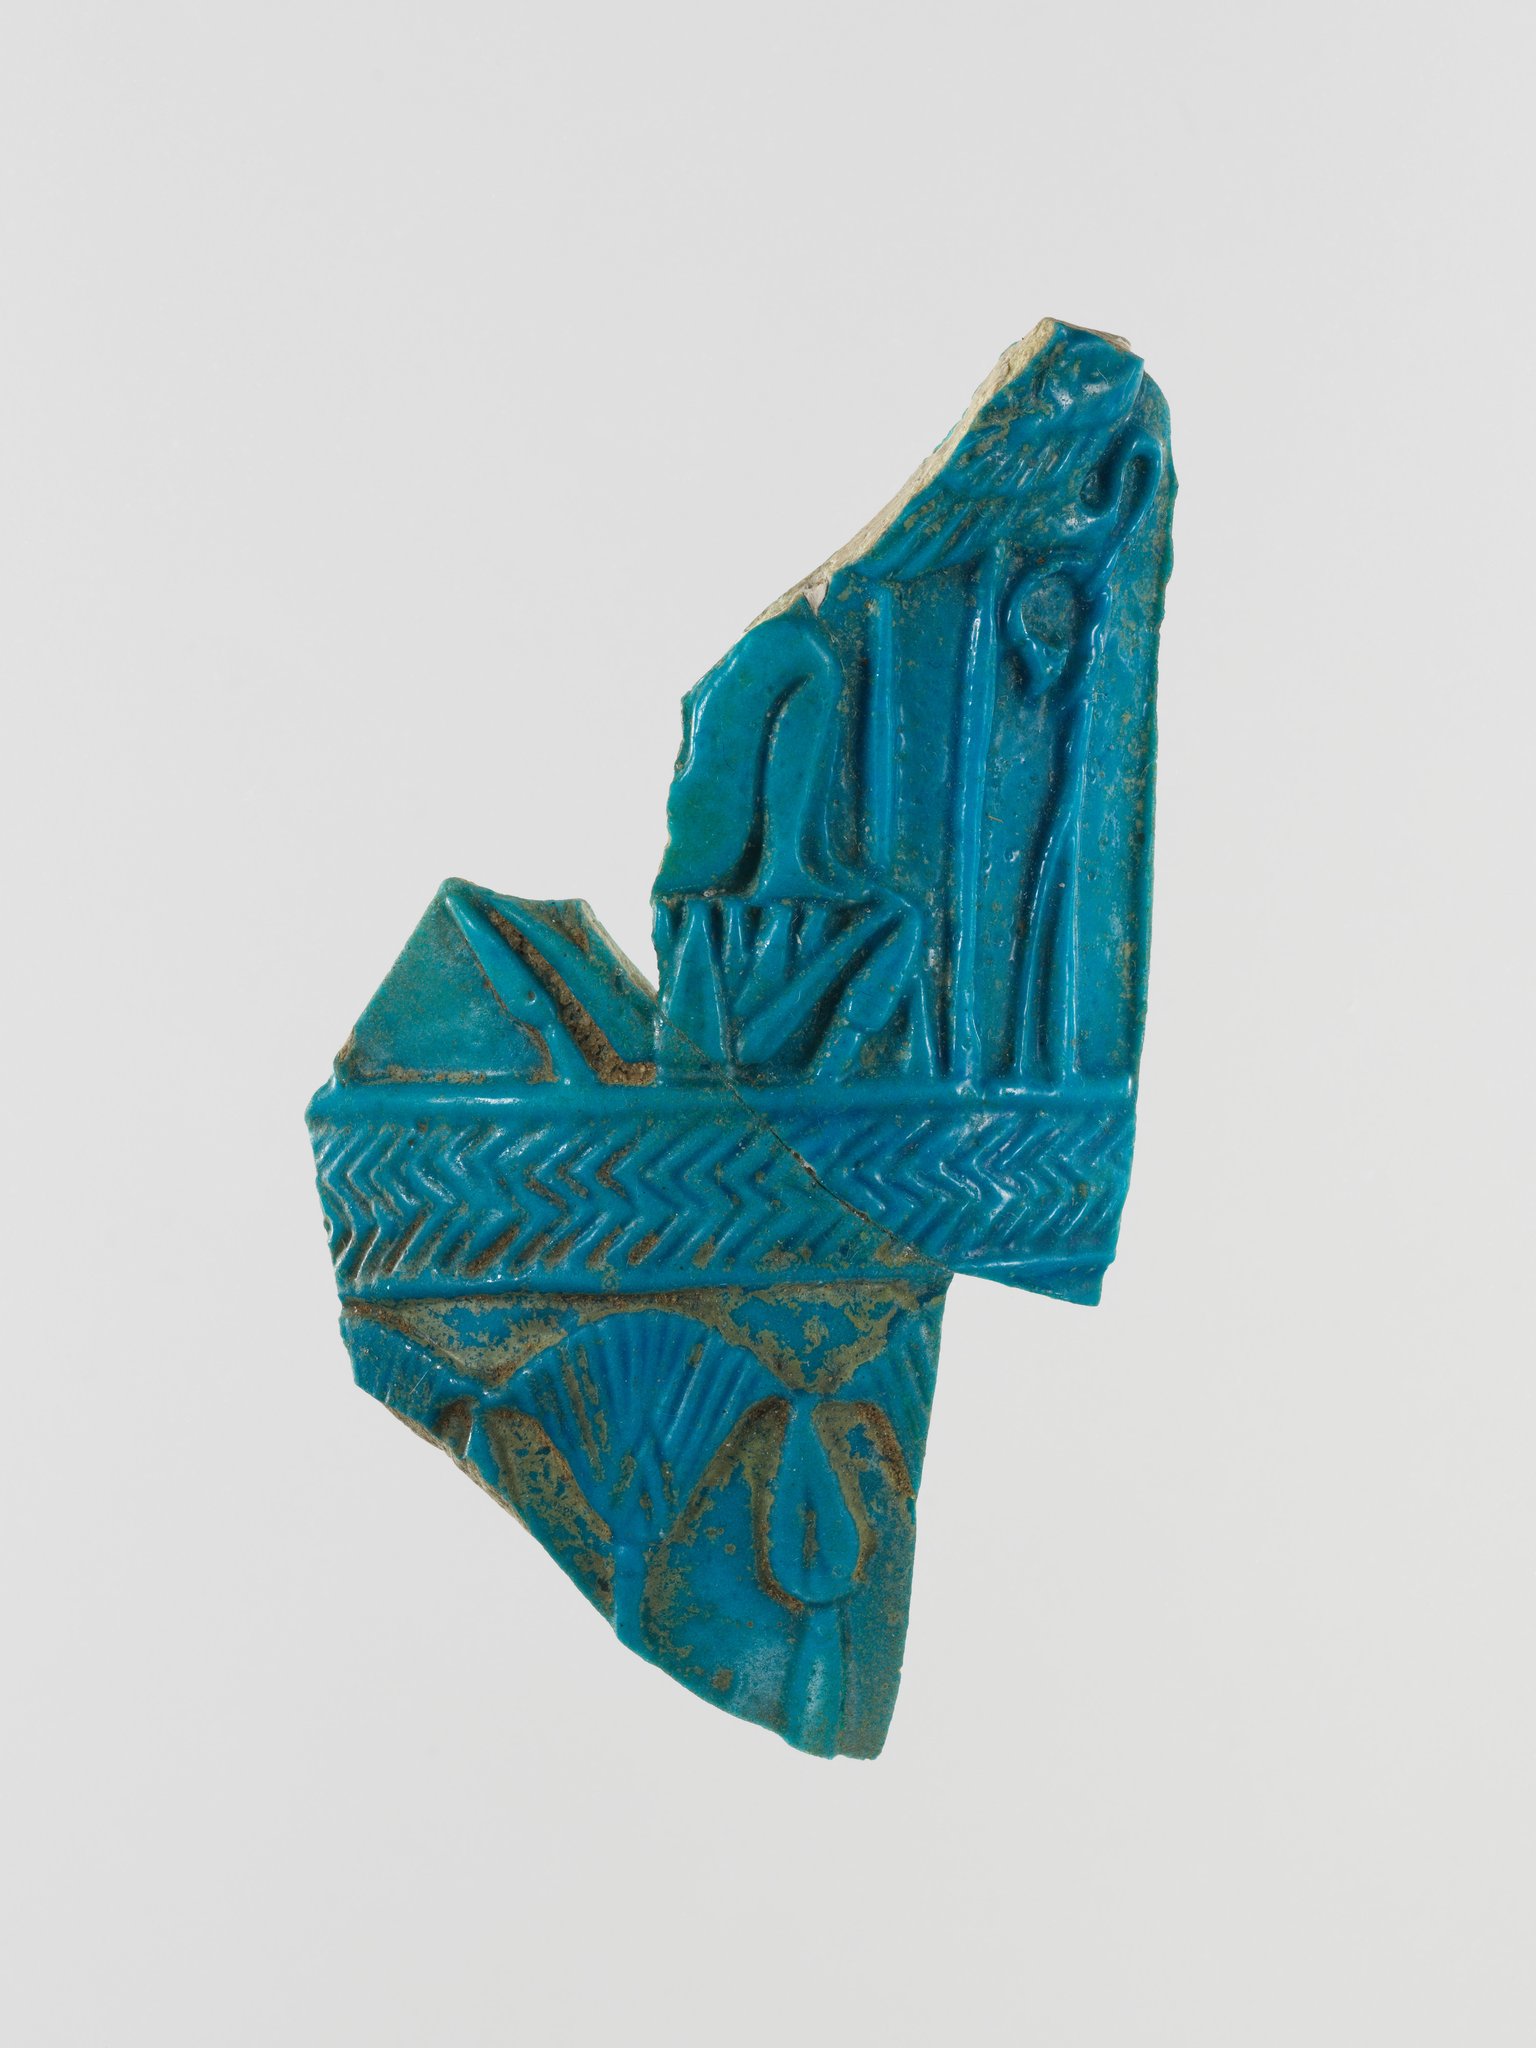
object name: chalice, cup, lotiform, relief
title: See 30.8.154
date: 1070-925 BCE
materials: faience